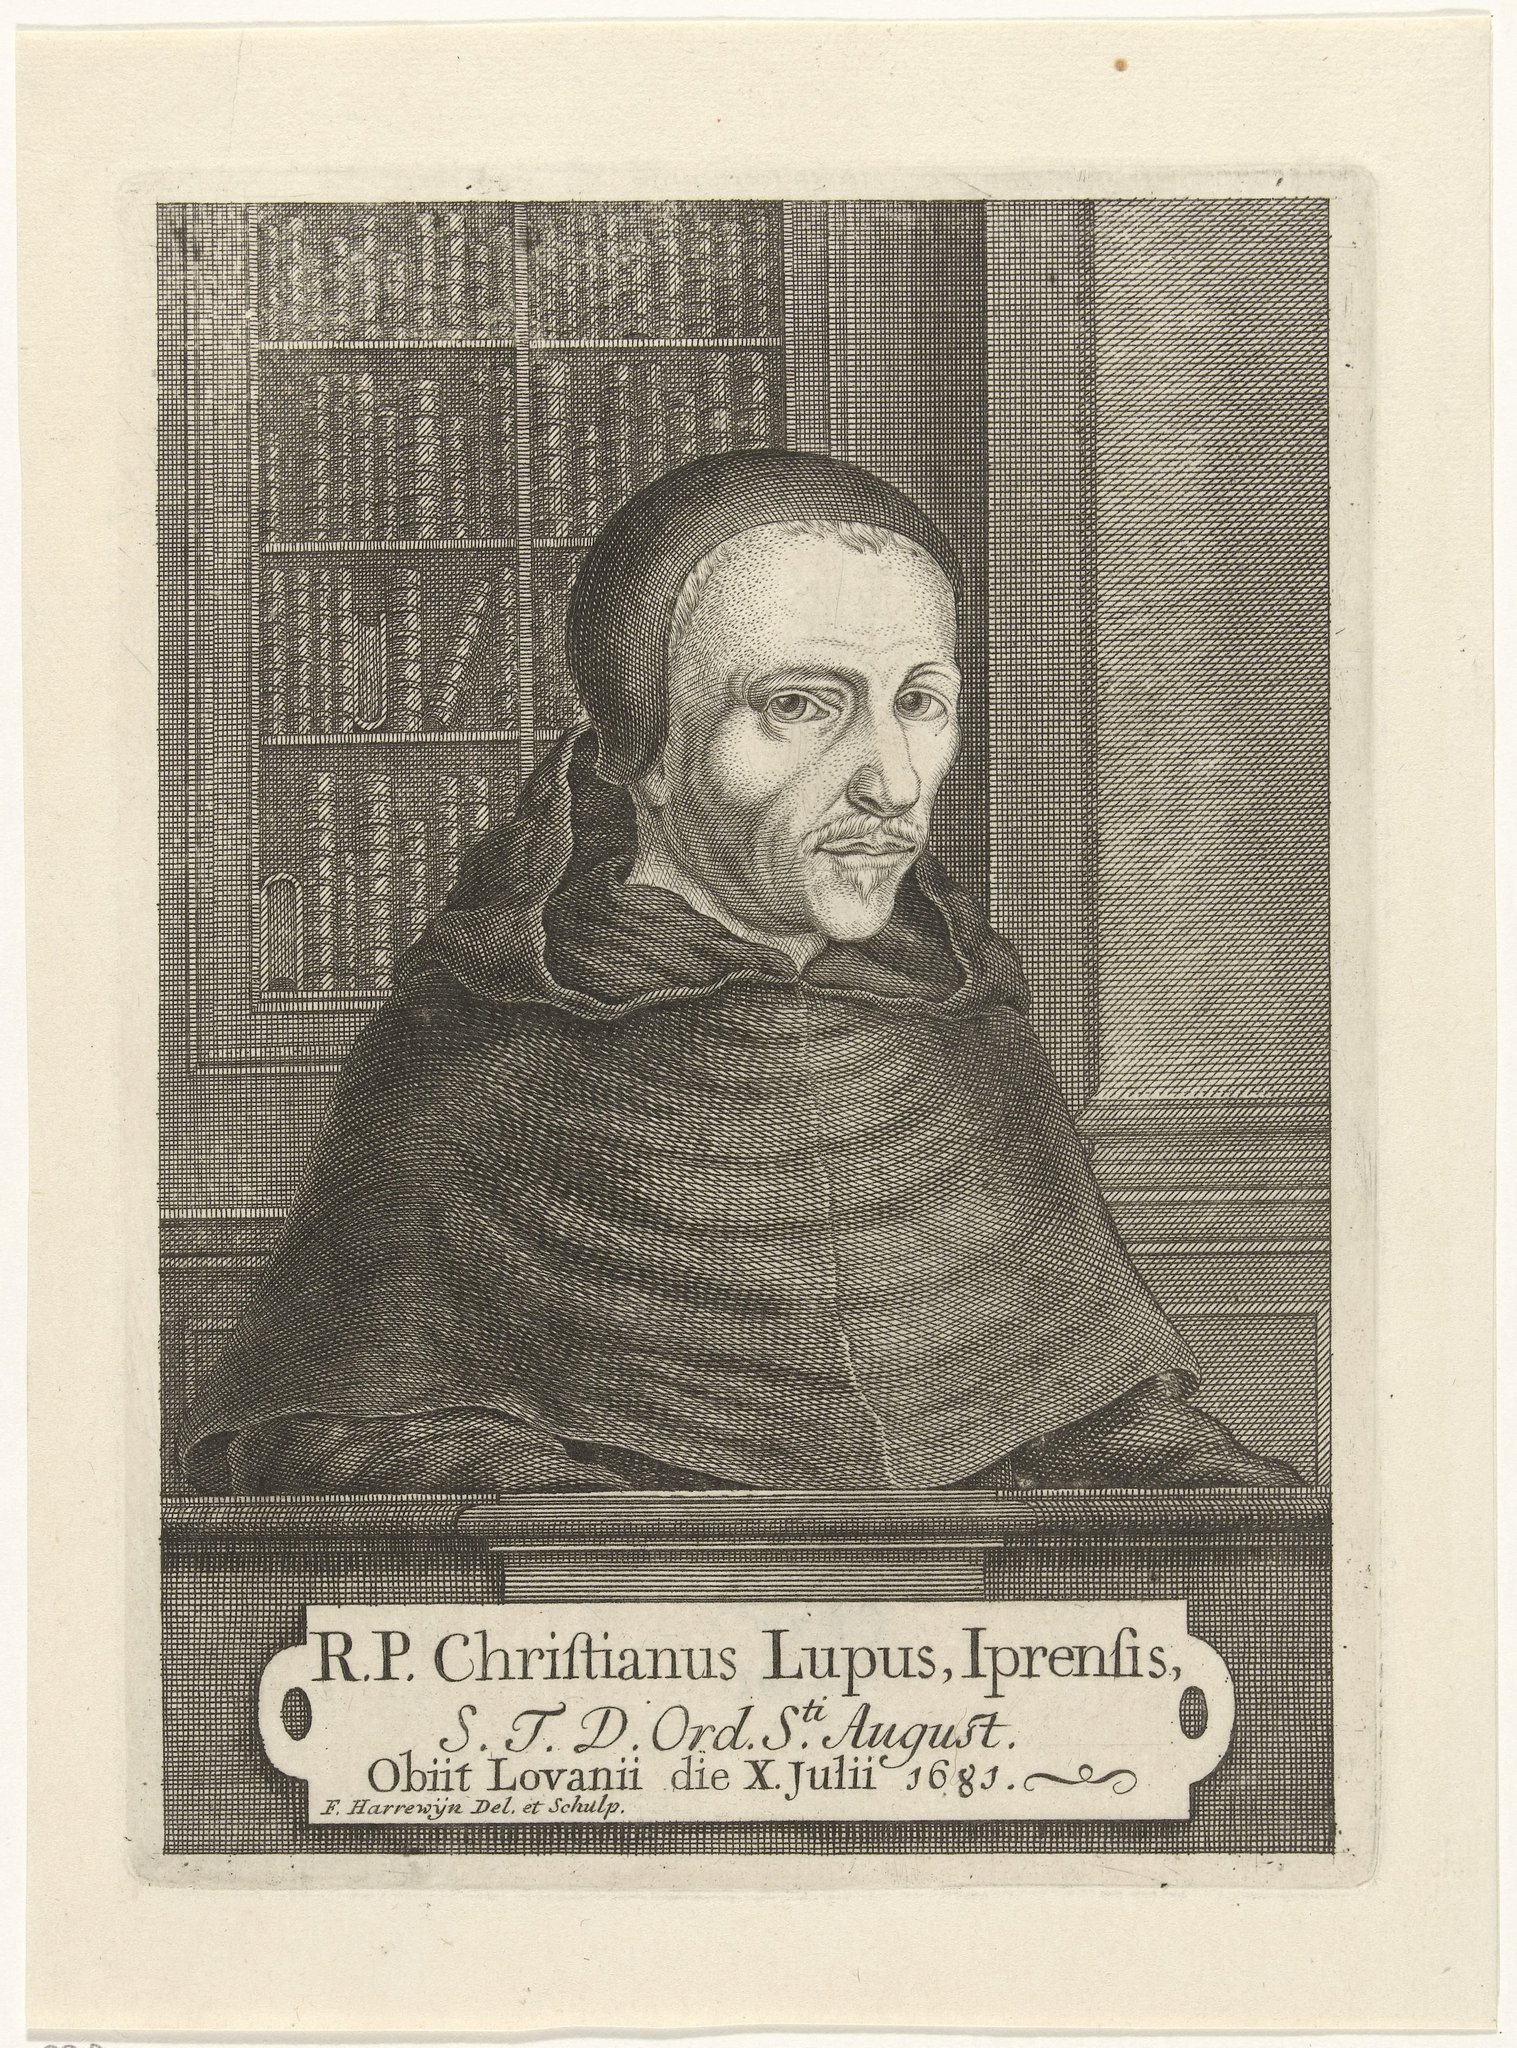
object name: print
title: Portret van Christianus Lupus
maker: françois harrewijn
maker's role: print maker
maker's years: 1700-1764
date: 1710-1764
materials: paper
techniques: engraving, etching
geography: brussels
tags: scholar in his study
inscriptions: collector's mark: Lugt 2228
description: Portret ten halven lijve naar rechts van de monnik en godgeleerde Christianus Lupus voor een boekenkast. Onder zijn portret een plint waarop zijn gegevens in drie regels in het Latijn.